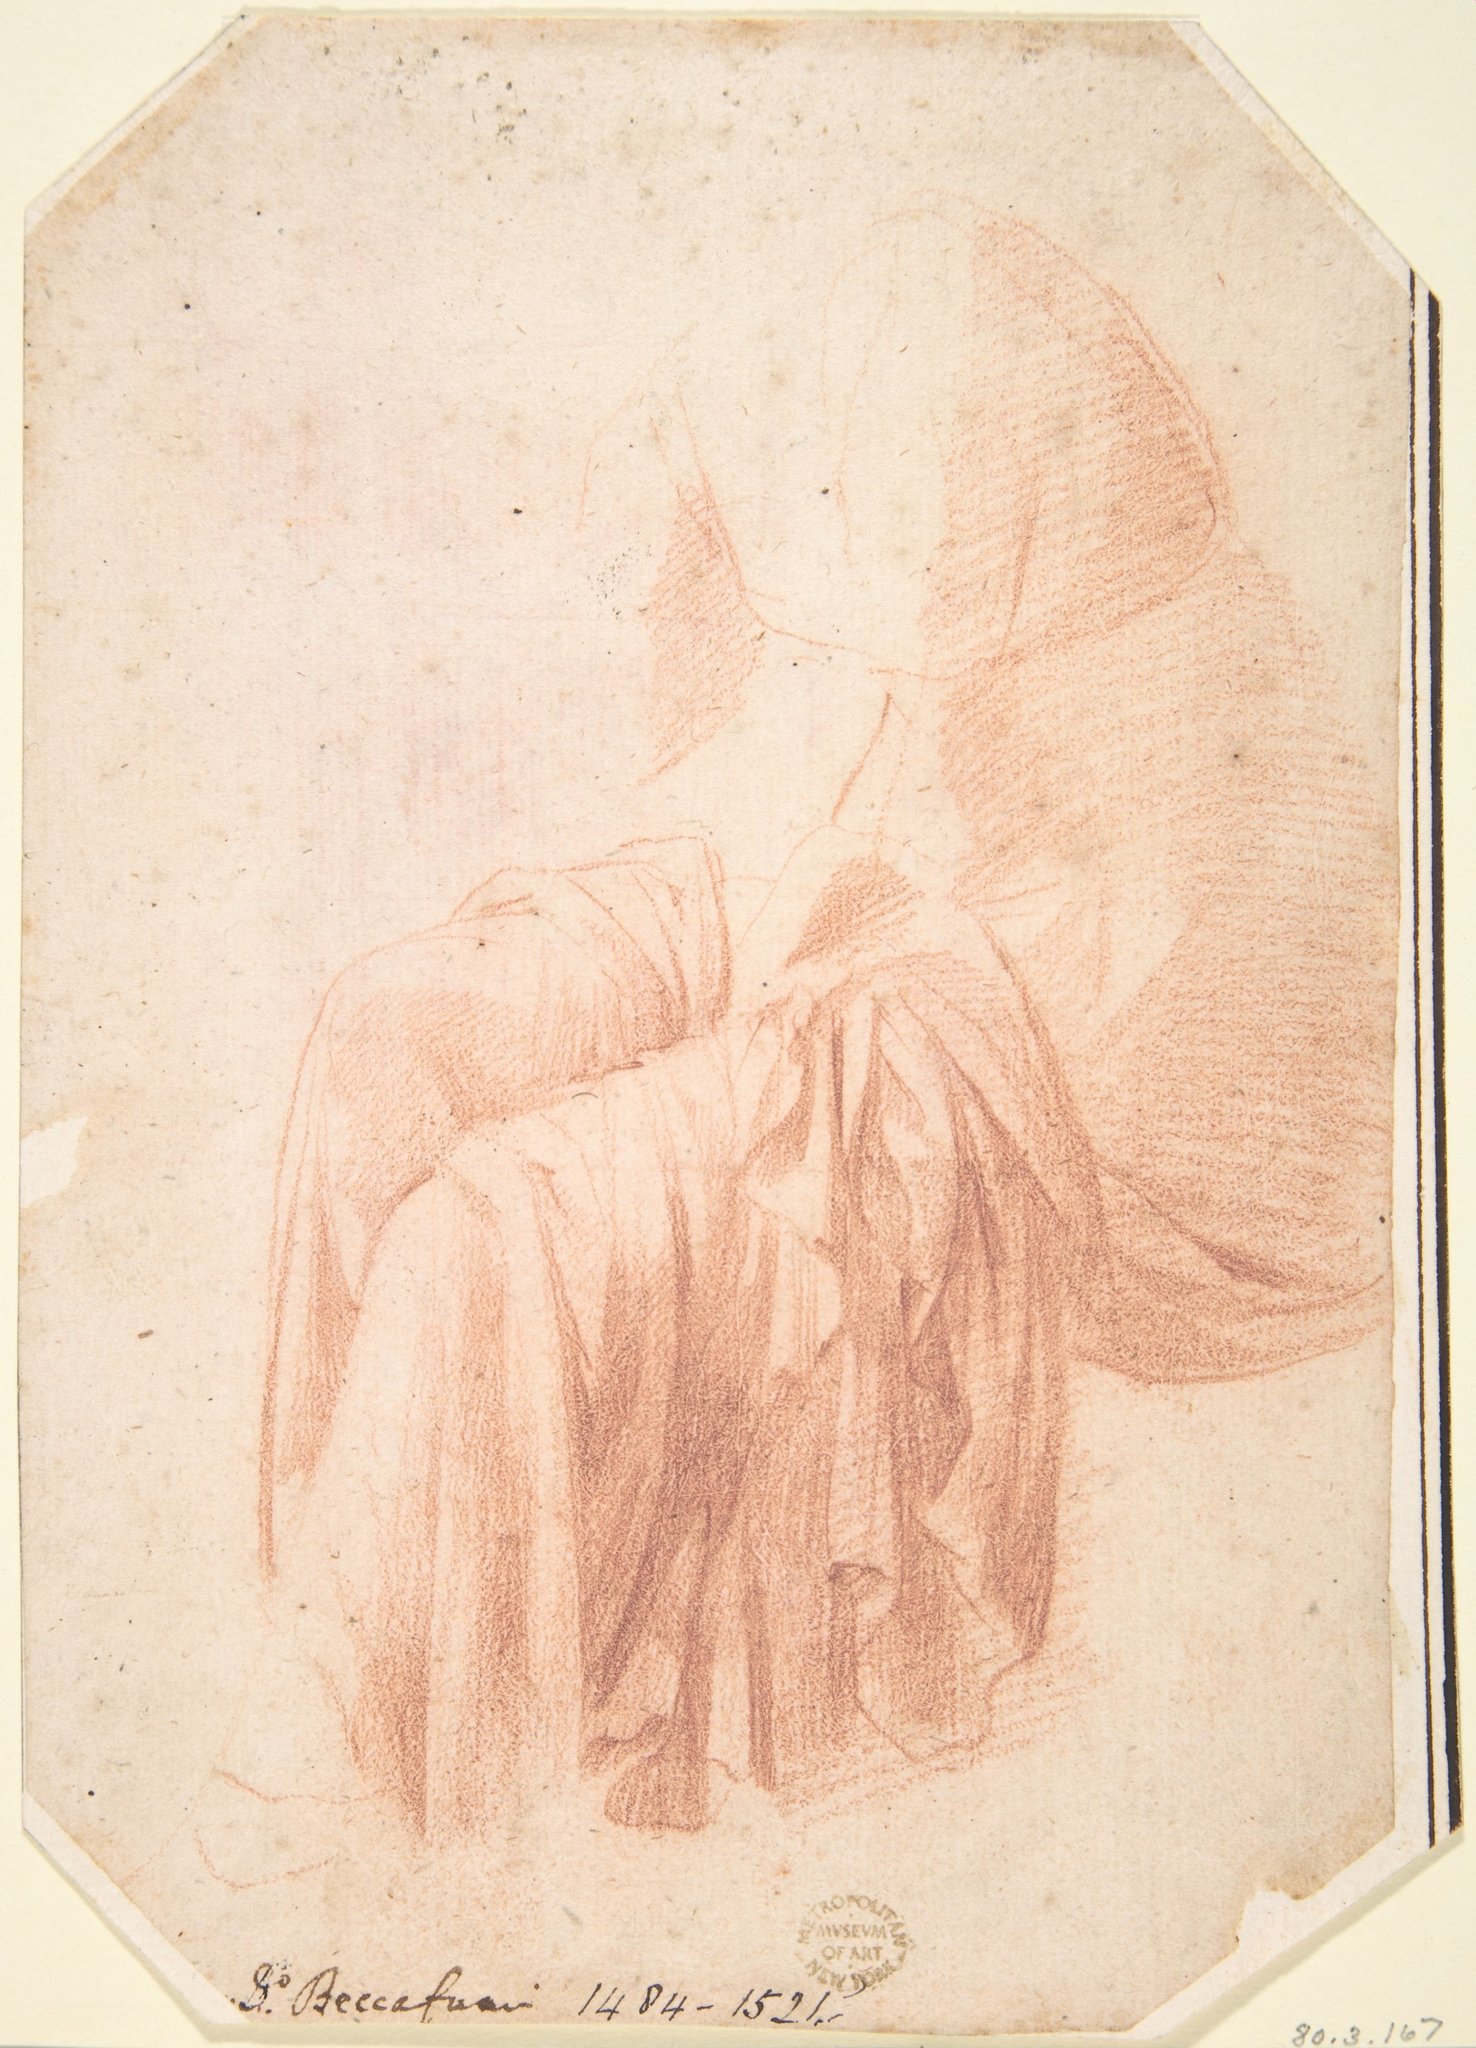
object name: drawing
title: Study of Drapery (Probably After the Antique)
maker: domenico beccafumi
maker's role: artist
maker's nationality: italian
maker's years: 1484-1551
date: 1520-1540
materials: chalk